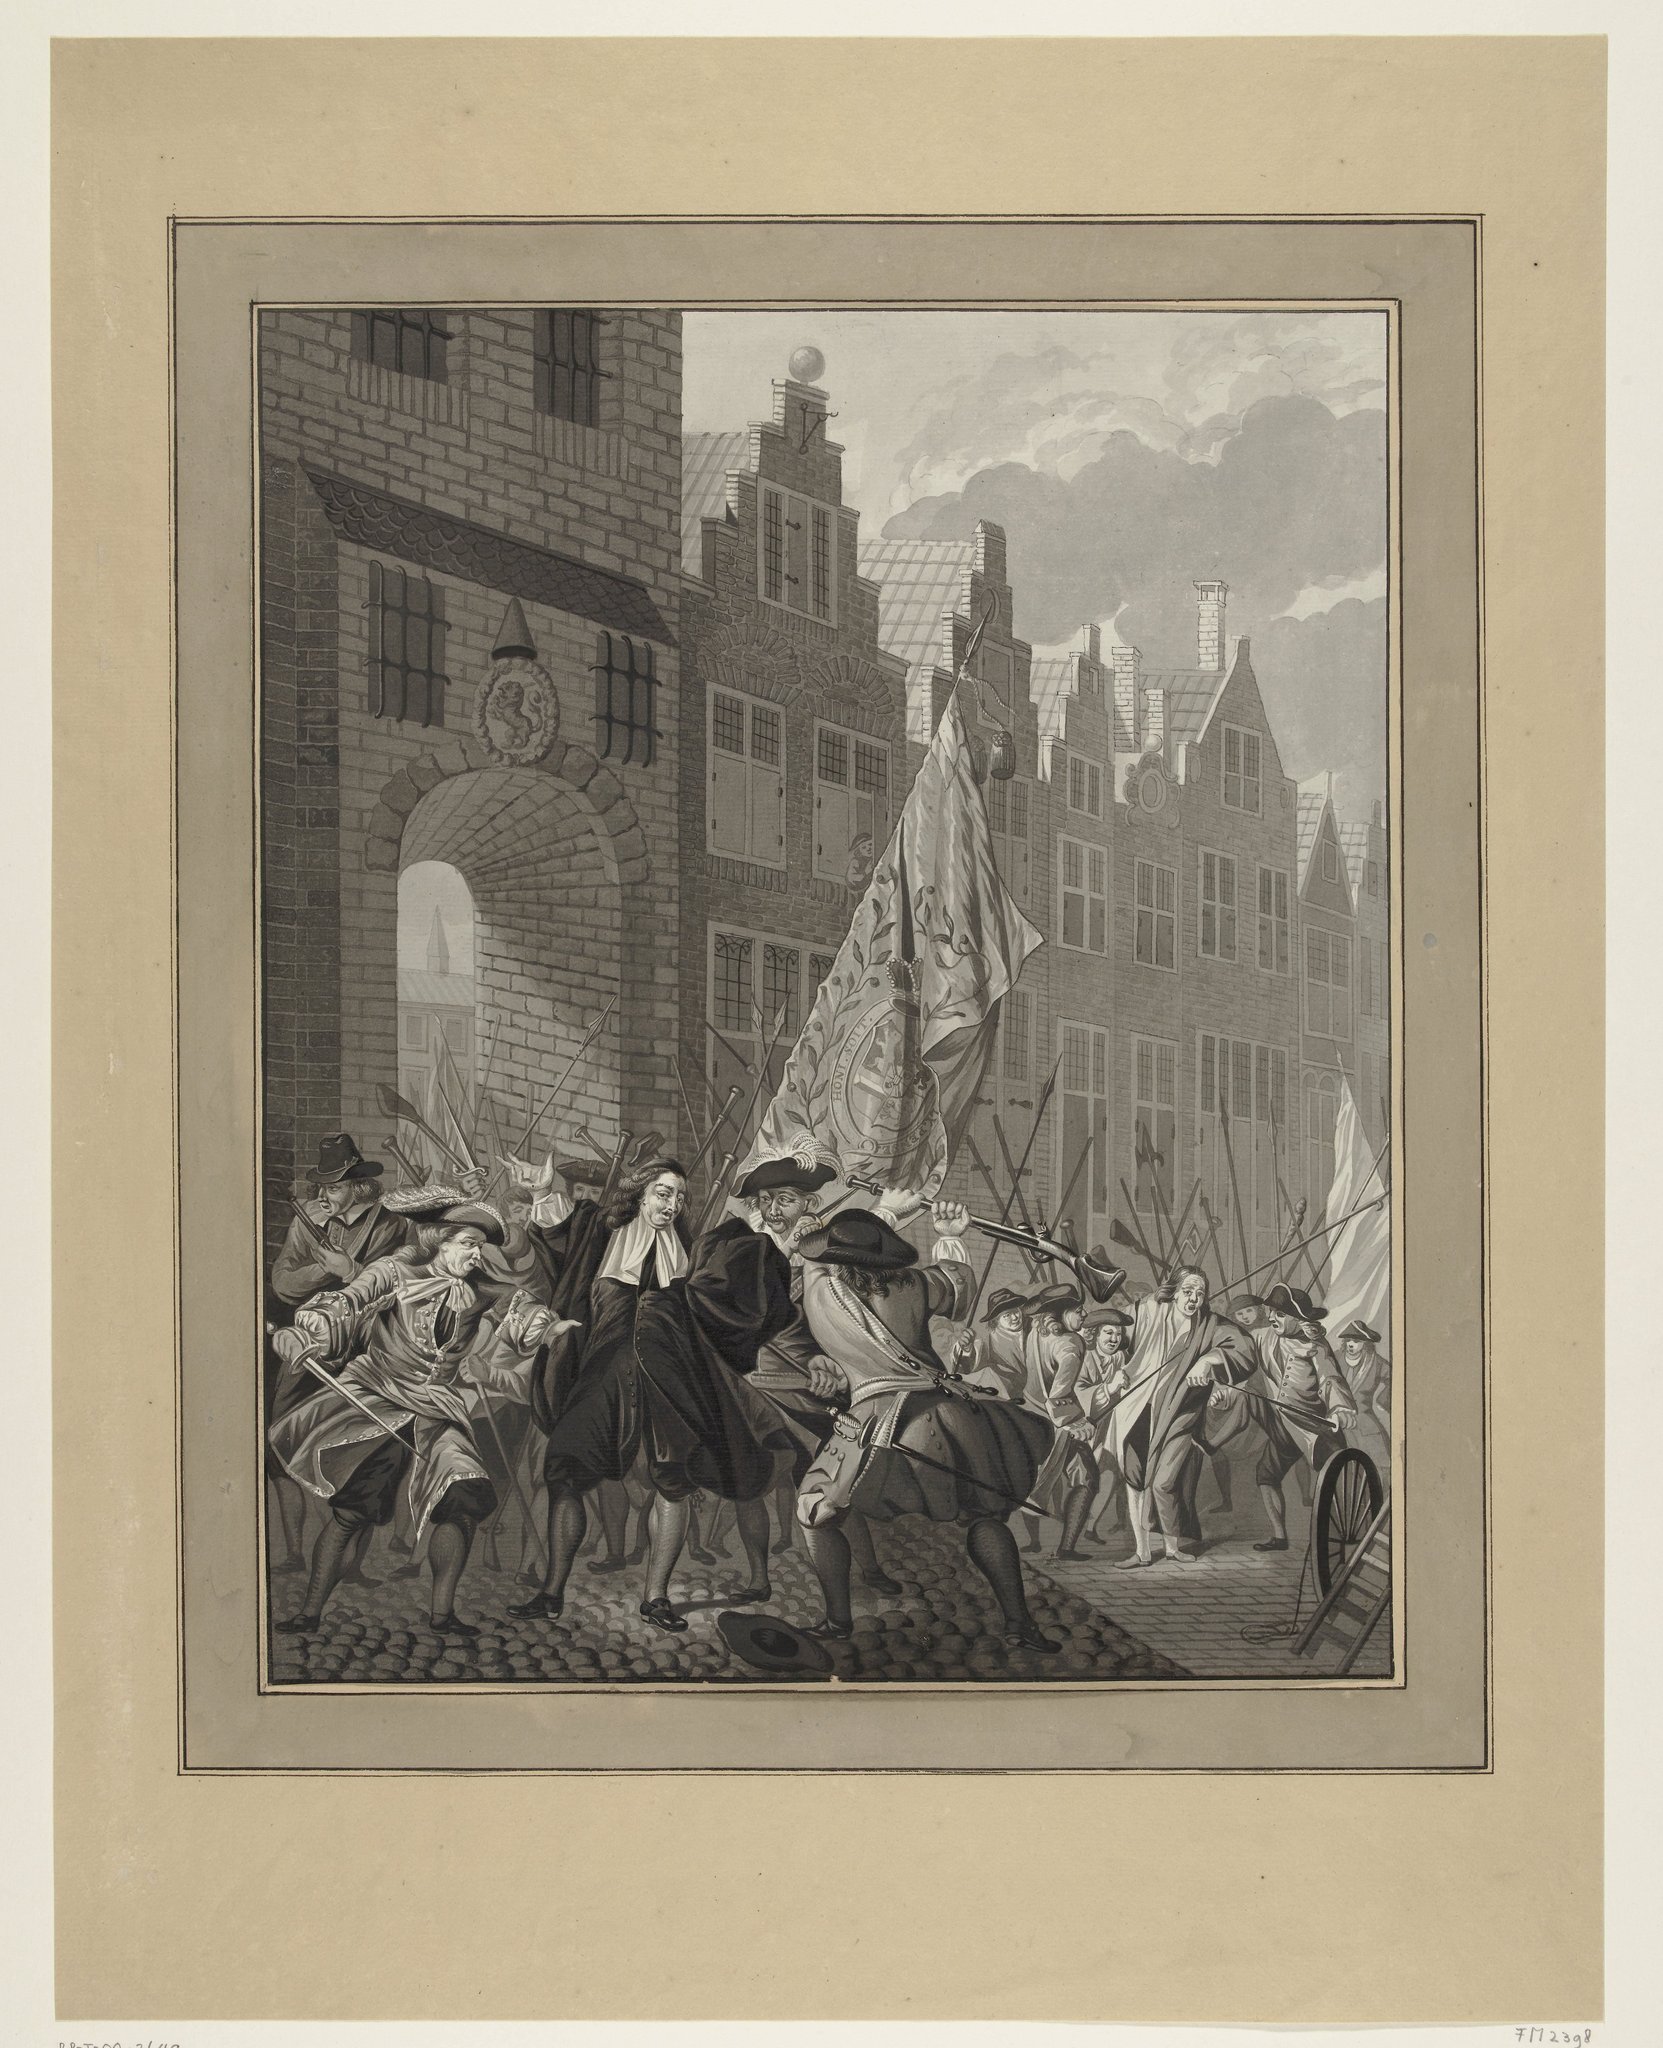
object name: drawing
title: Dood van de gebroeders De Witt, 1672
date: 1775-1799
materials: paper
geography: northern netherlands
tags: dordrecht, cornelis de witt, politician, johan de witt, lynching, the hague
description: Johan en Cornelis de Witt worden uit de Gevangenpoort te Den Haag gehaald en op straat door de woedende menigte gedood, 20 augustus 1672. Soldaten voeren de vaandel van de prins Willem III.